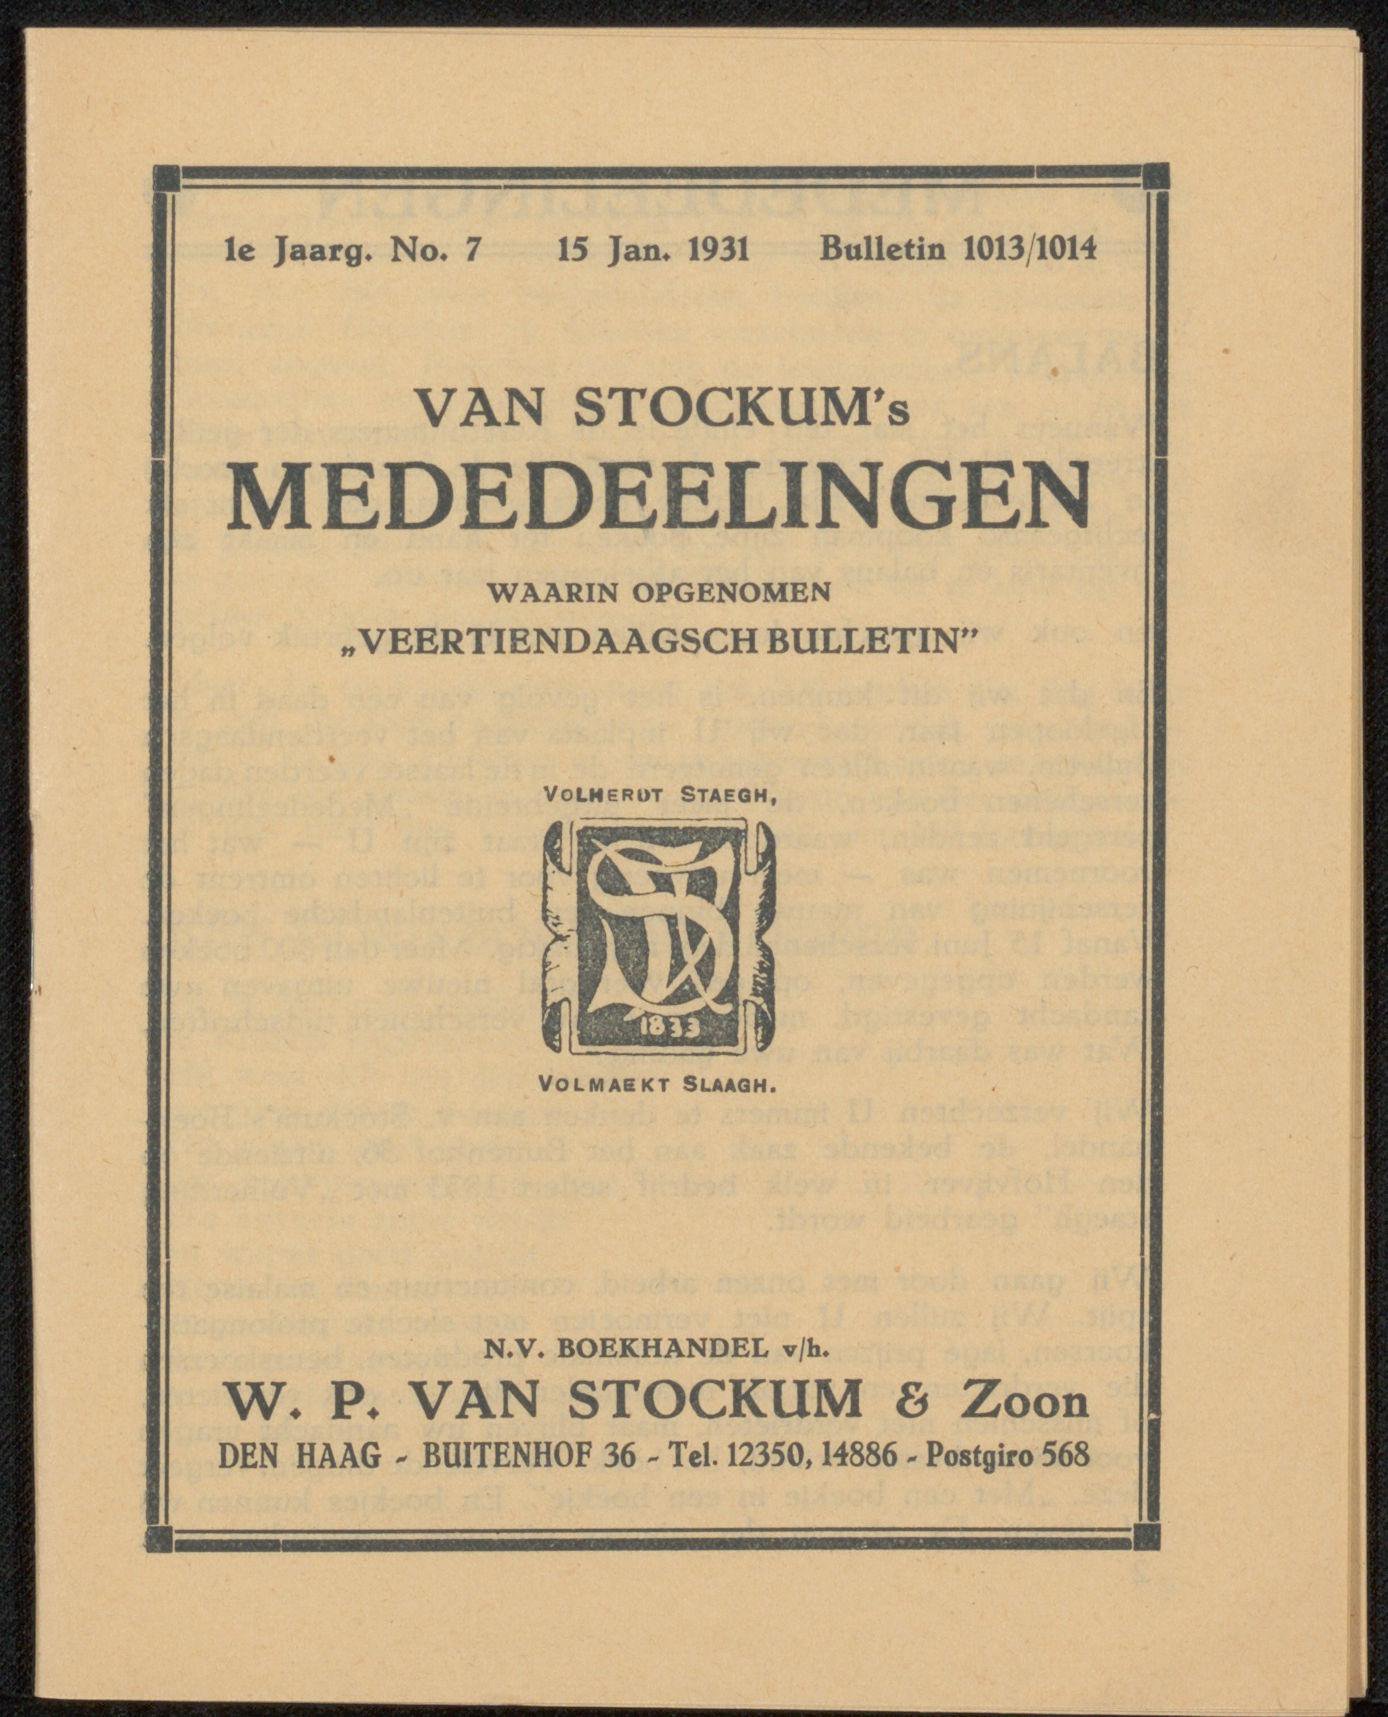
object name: folder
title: Folder uit archief Philip Zilcken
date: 1931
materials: paper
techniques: printing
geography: the hague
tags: henriette wilhelmina van baak, the hague, painter, draughtsman, philip zilcken